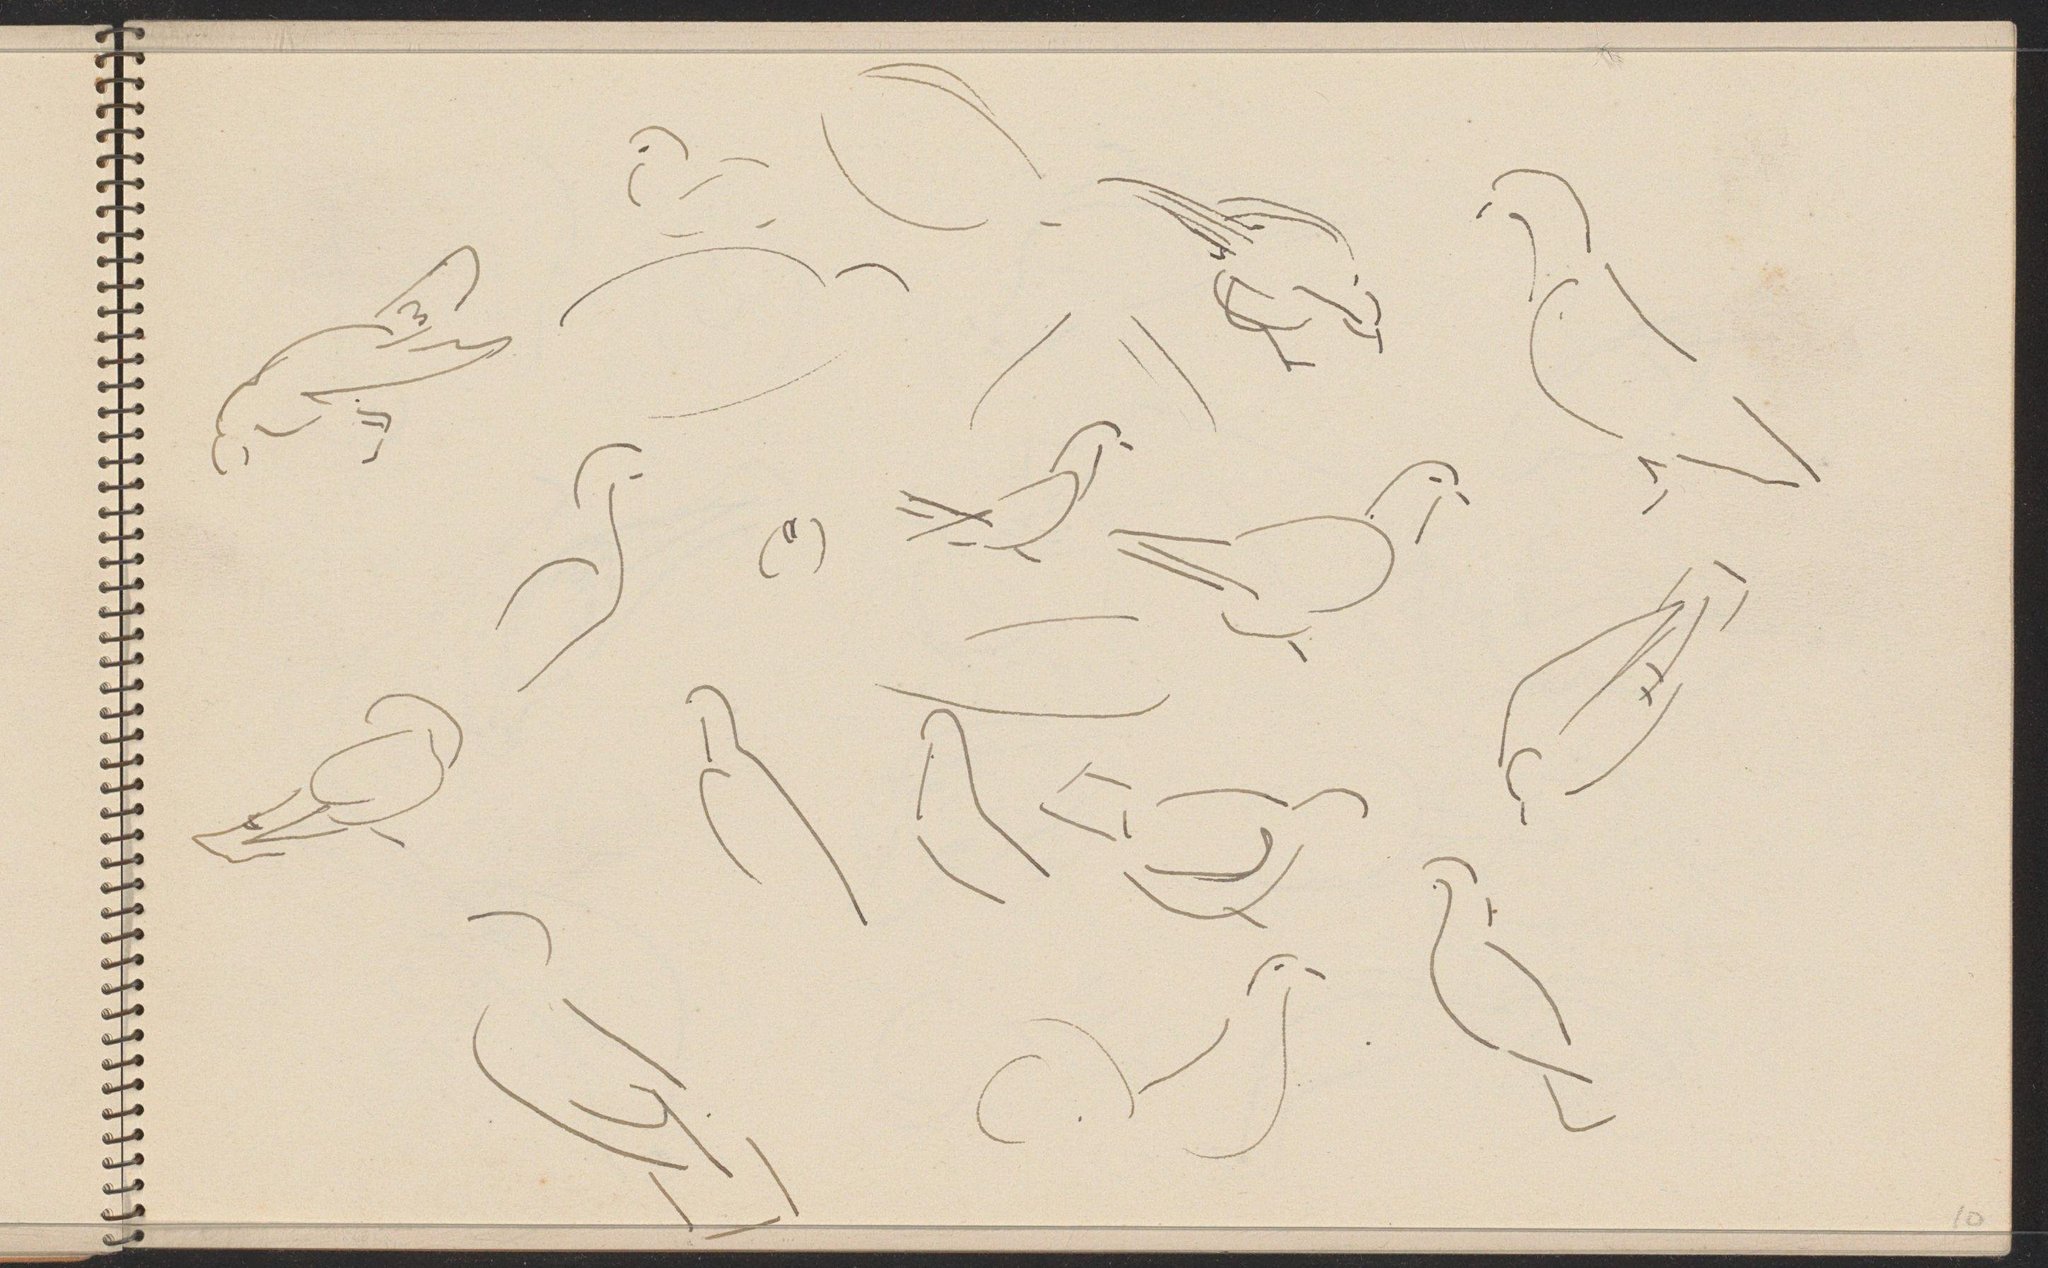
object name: sketchbook leaf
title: Duiven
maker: carel adolph lion cachet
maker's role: draughtsman, print maker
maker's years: 1864-1945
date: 1935-1940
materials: ink, paper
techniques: pen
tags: doves, pigeons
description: Blad 10 recto uit een schetsboek met 25 bladen.